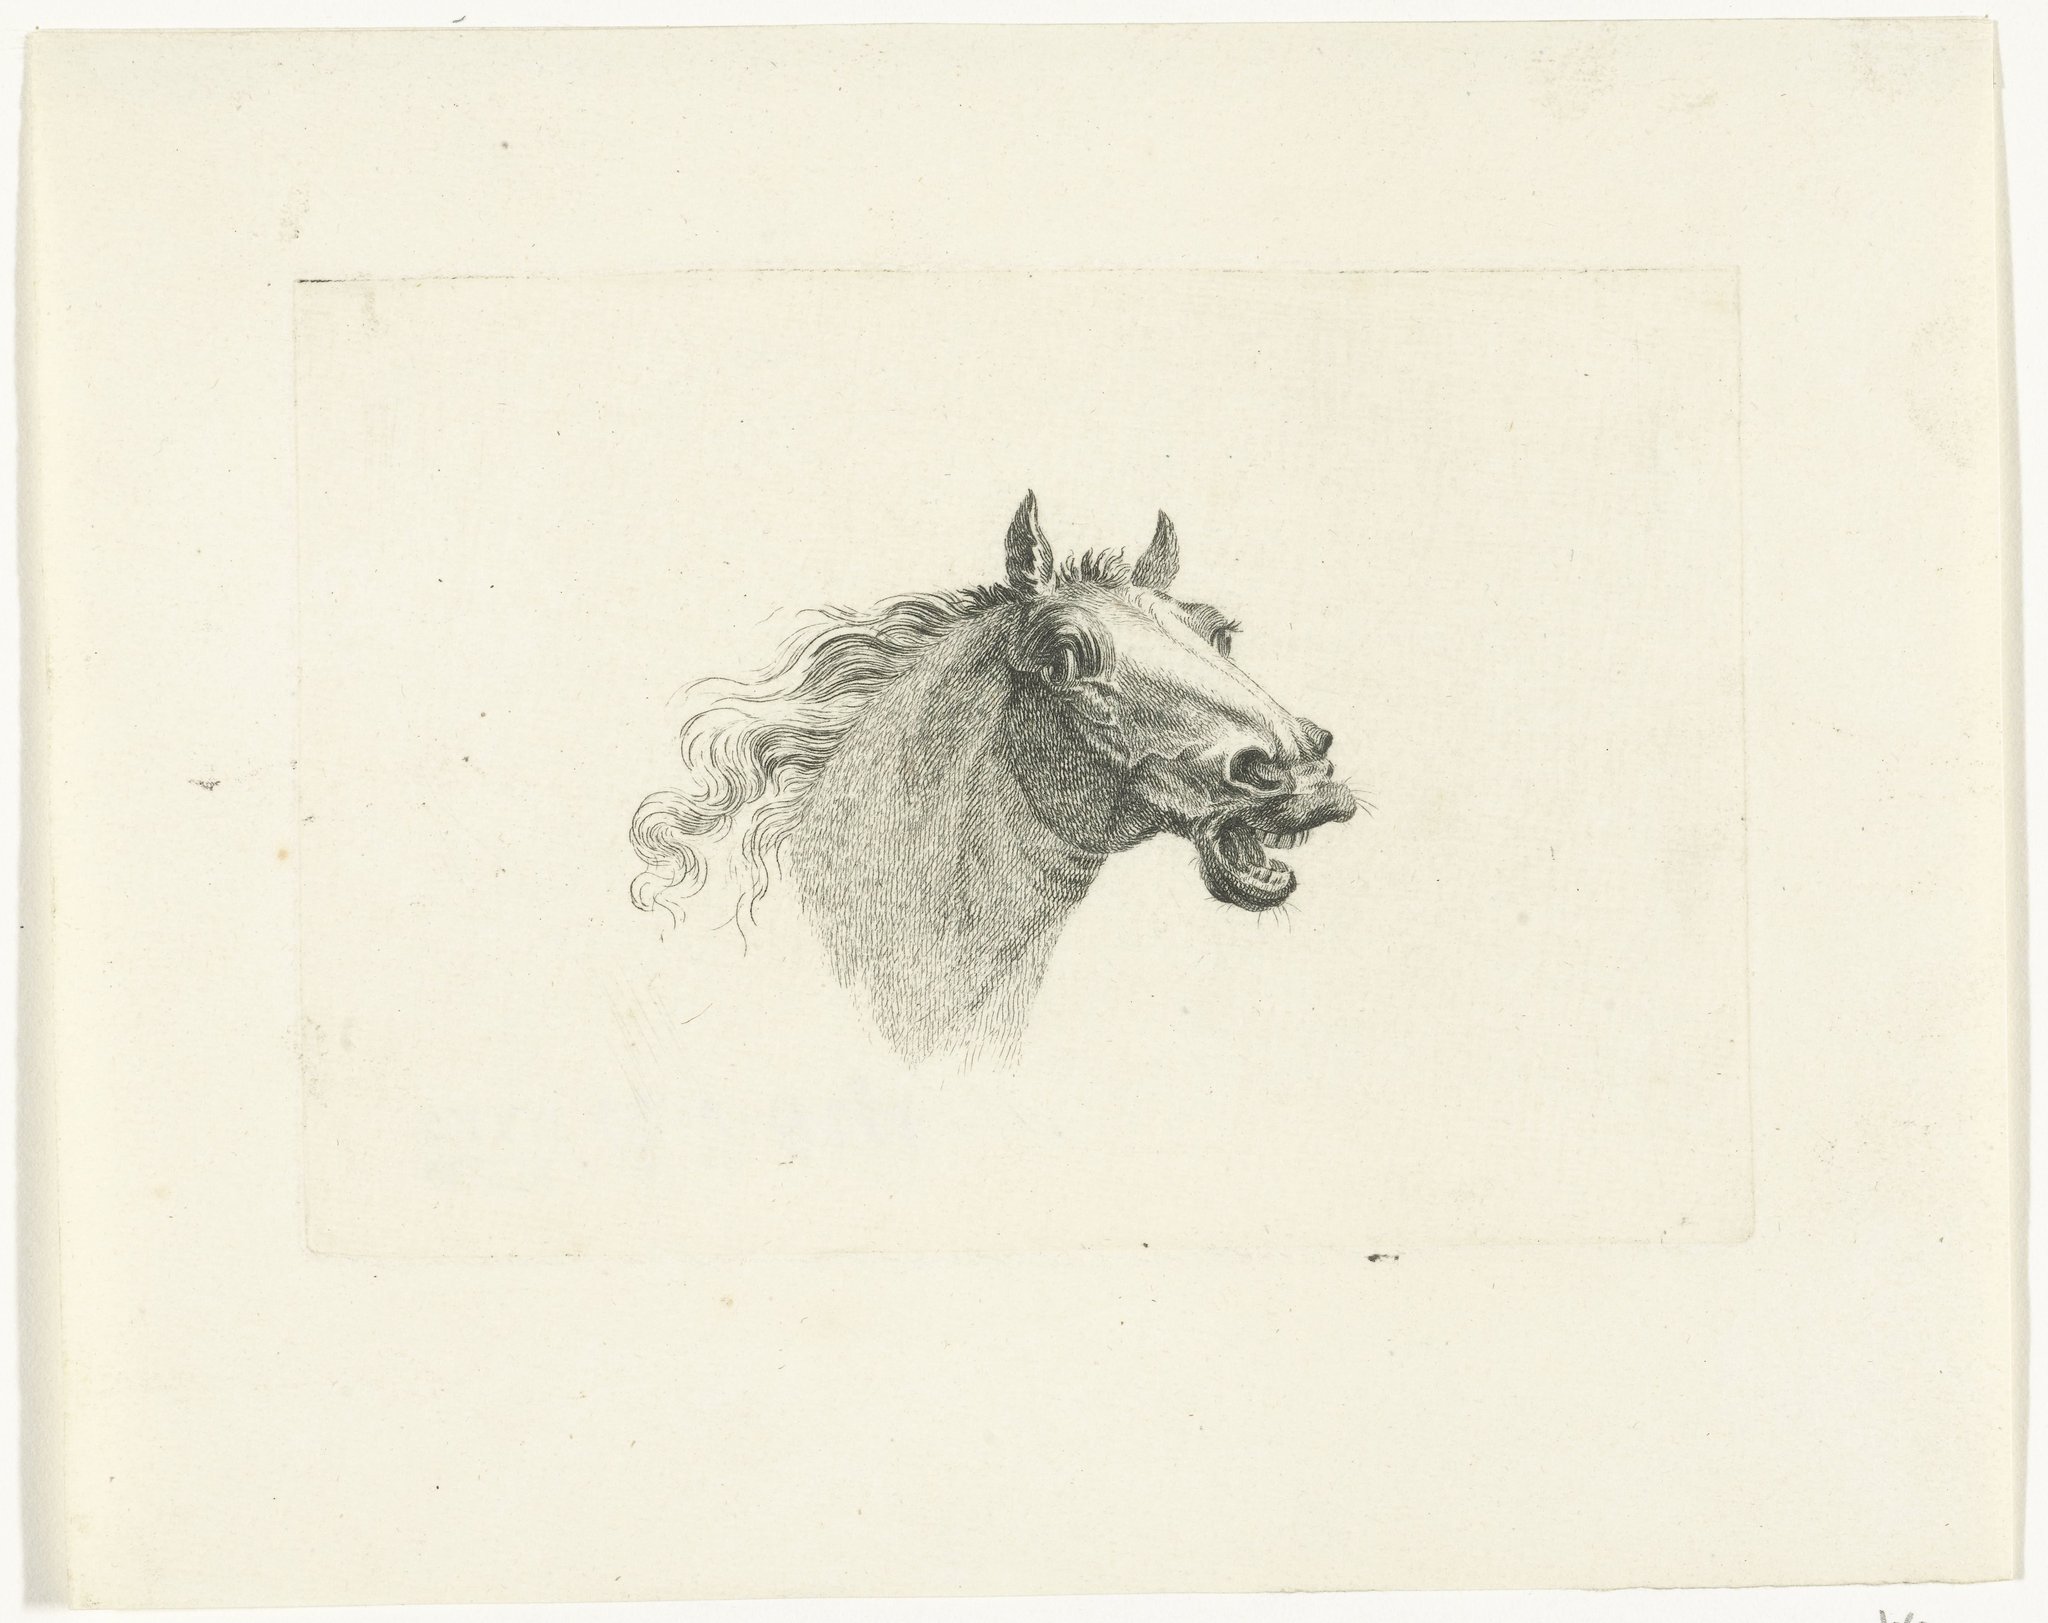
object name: print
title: Paardenkoppen naar Gerrit Malleyn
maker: joannes bemme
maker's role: print maker, printer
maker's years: 1775-1841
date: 1801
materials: paper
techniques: etching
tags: horse (+ head of an animal)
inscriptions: collector's mark: Lugt 2165